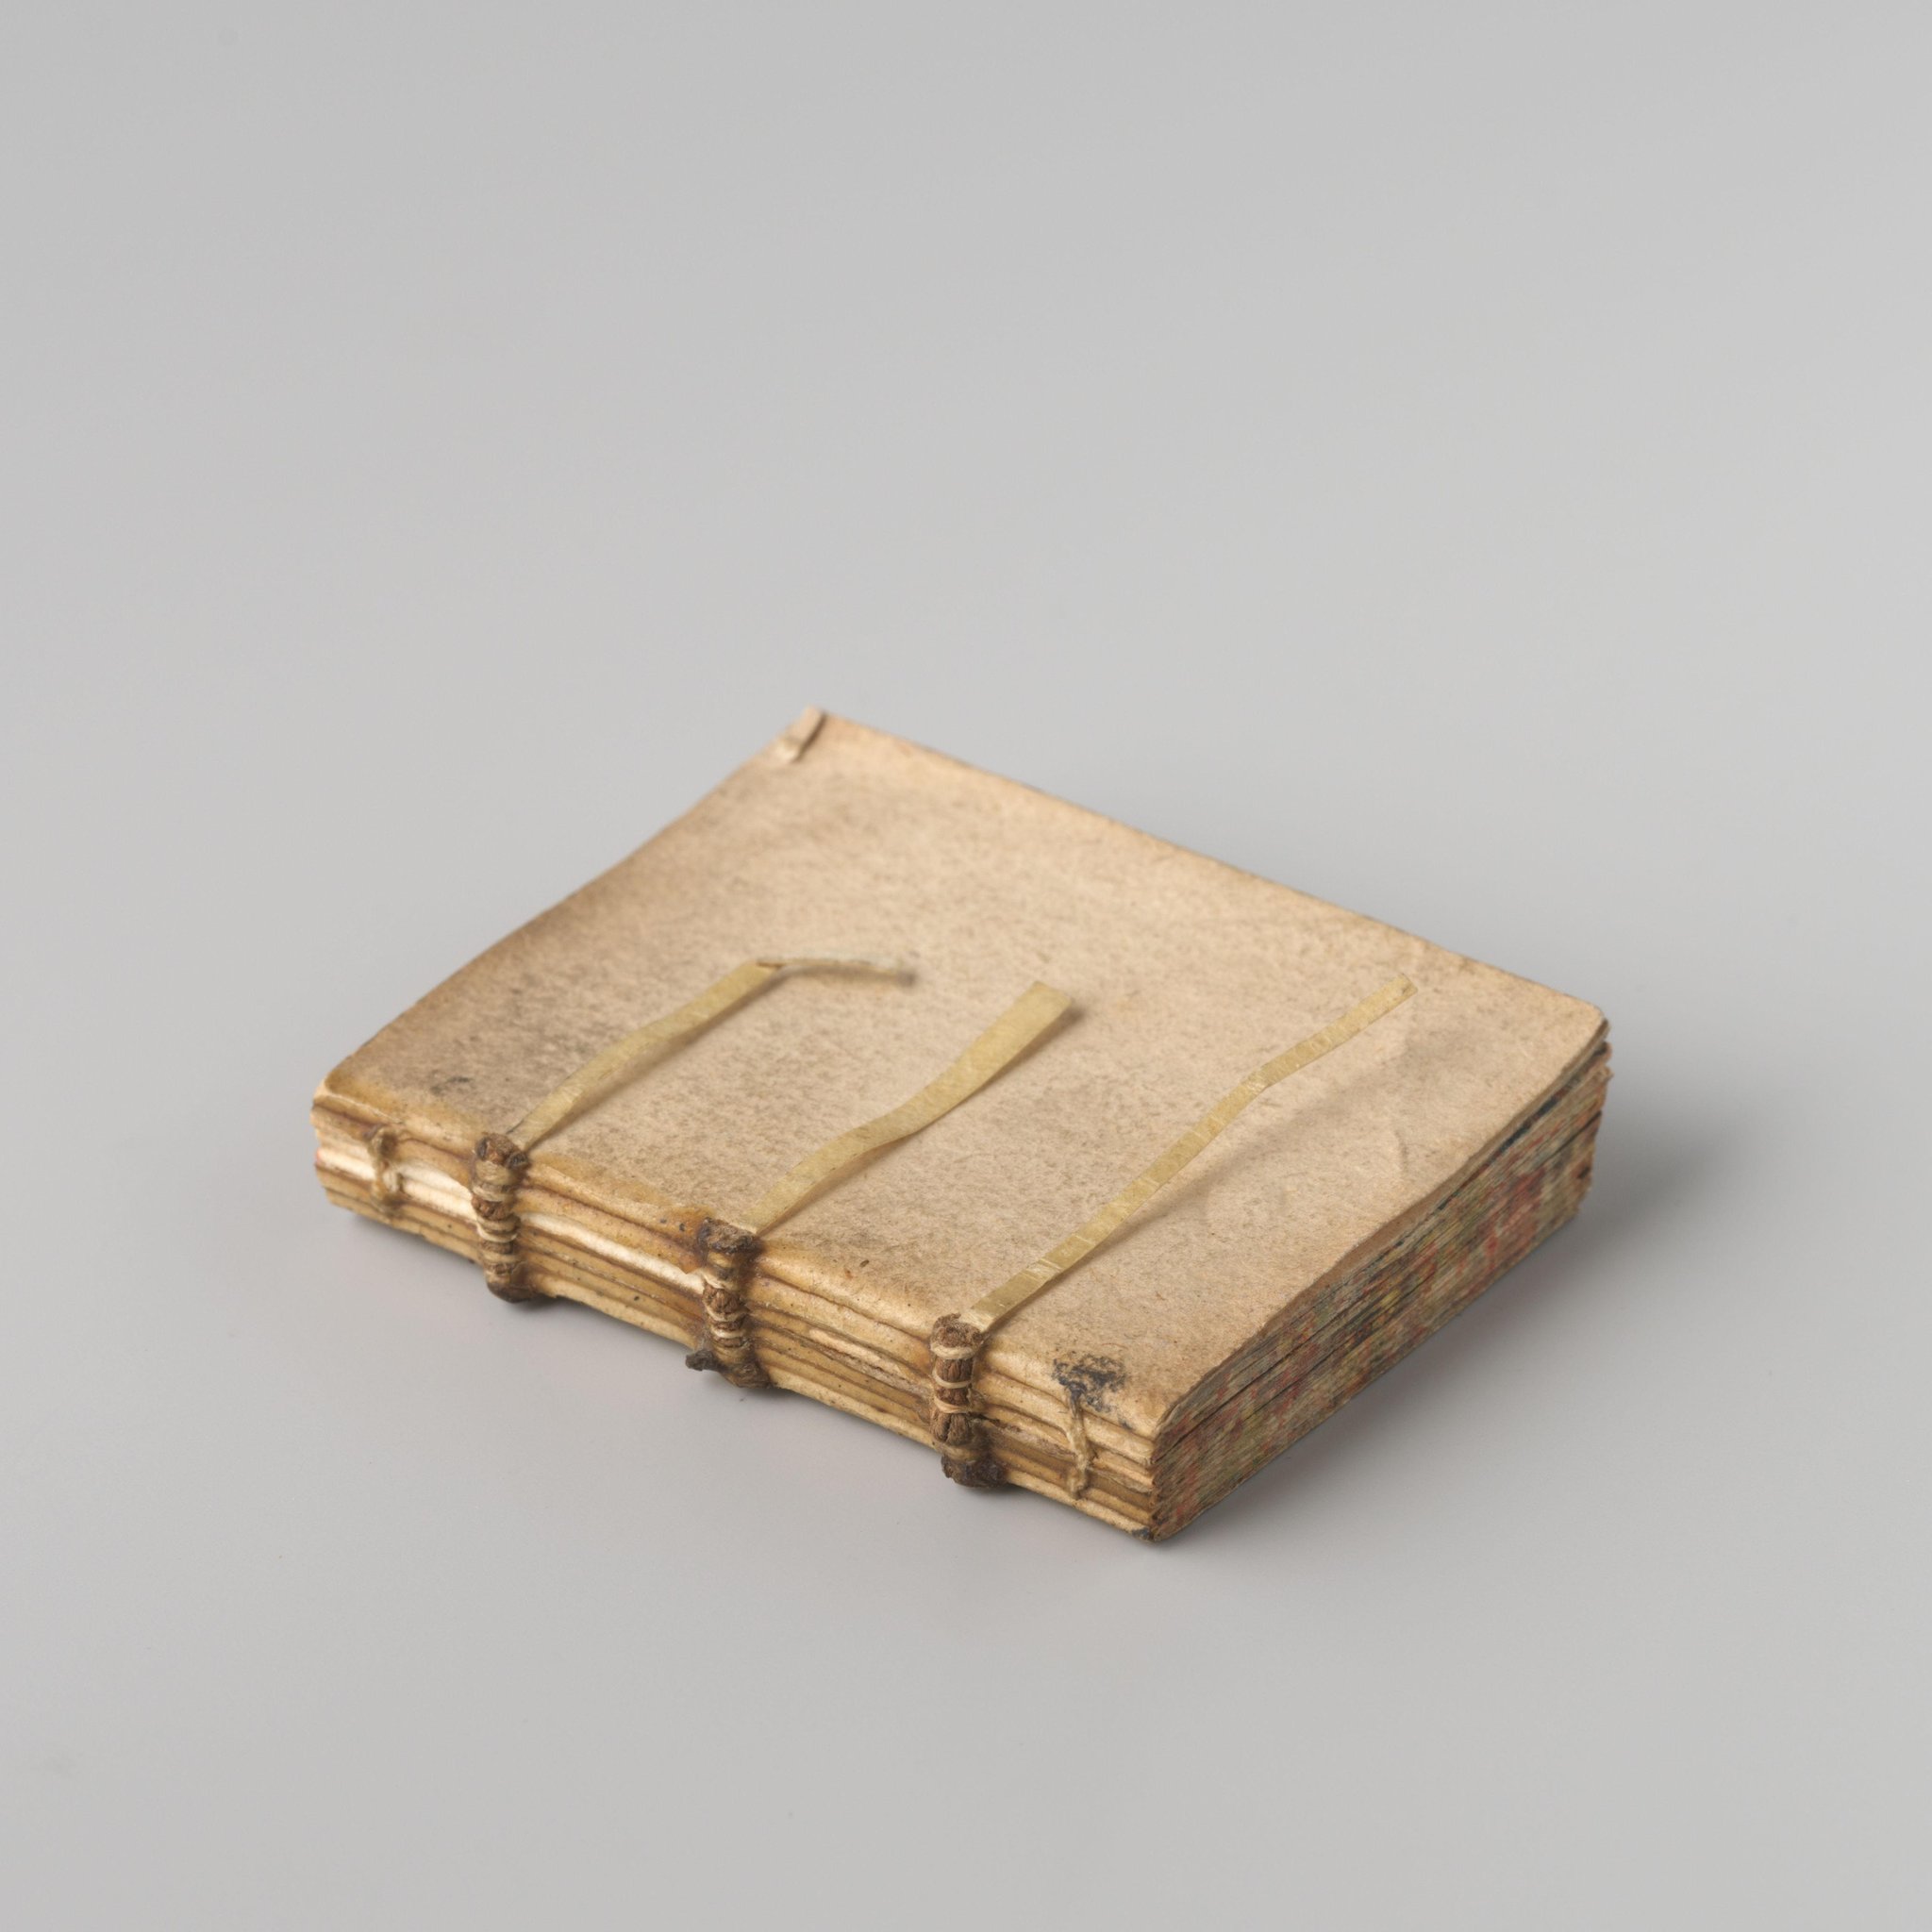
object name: book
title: Boekblok met stadsprofielen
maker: Anonymous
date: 1690-1710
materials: paper, parchment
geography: amsterdam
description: Boekblok met stadsprofielen. Het boekblok bestaat uit zes katernen van vier bladen, samengenaaid met draad en perkamenten boekriemen. De snede is gespat.